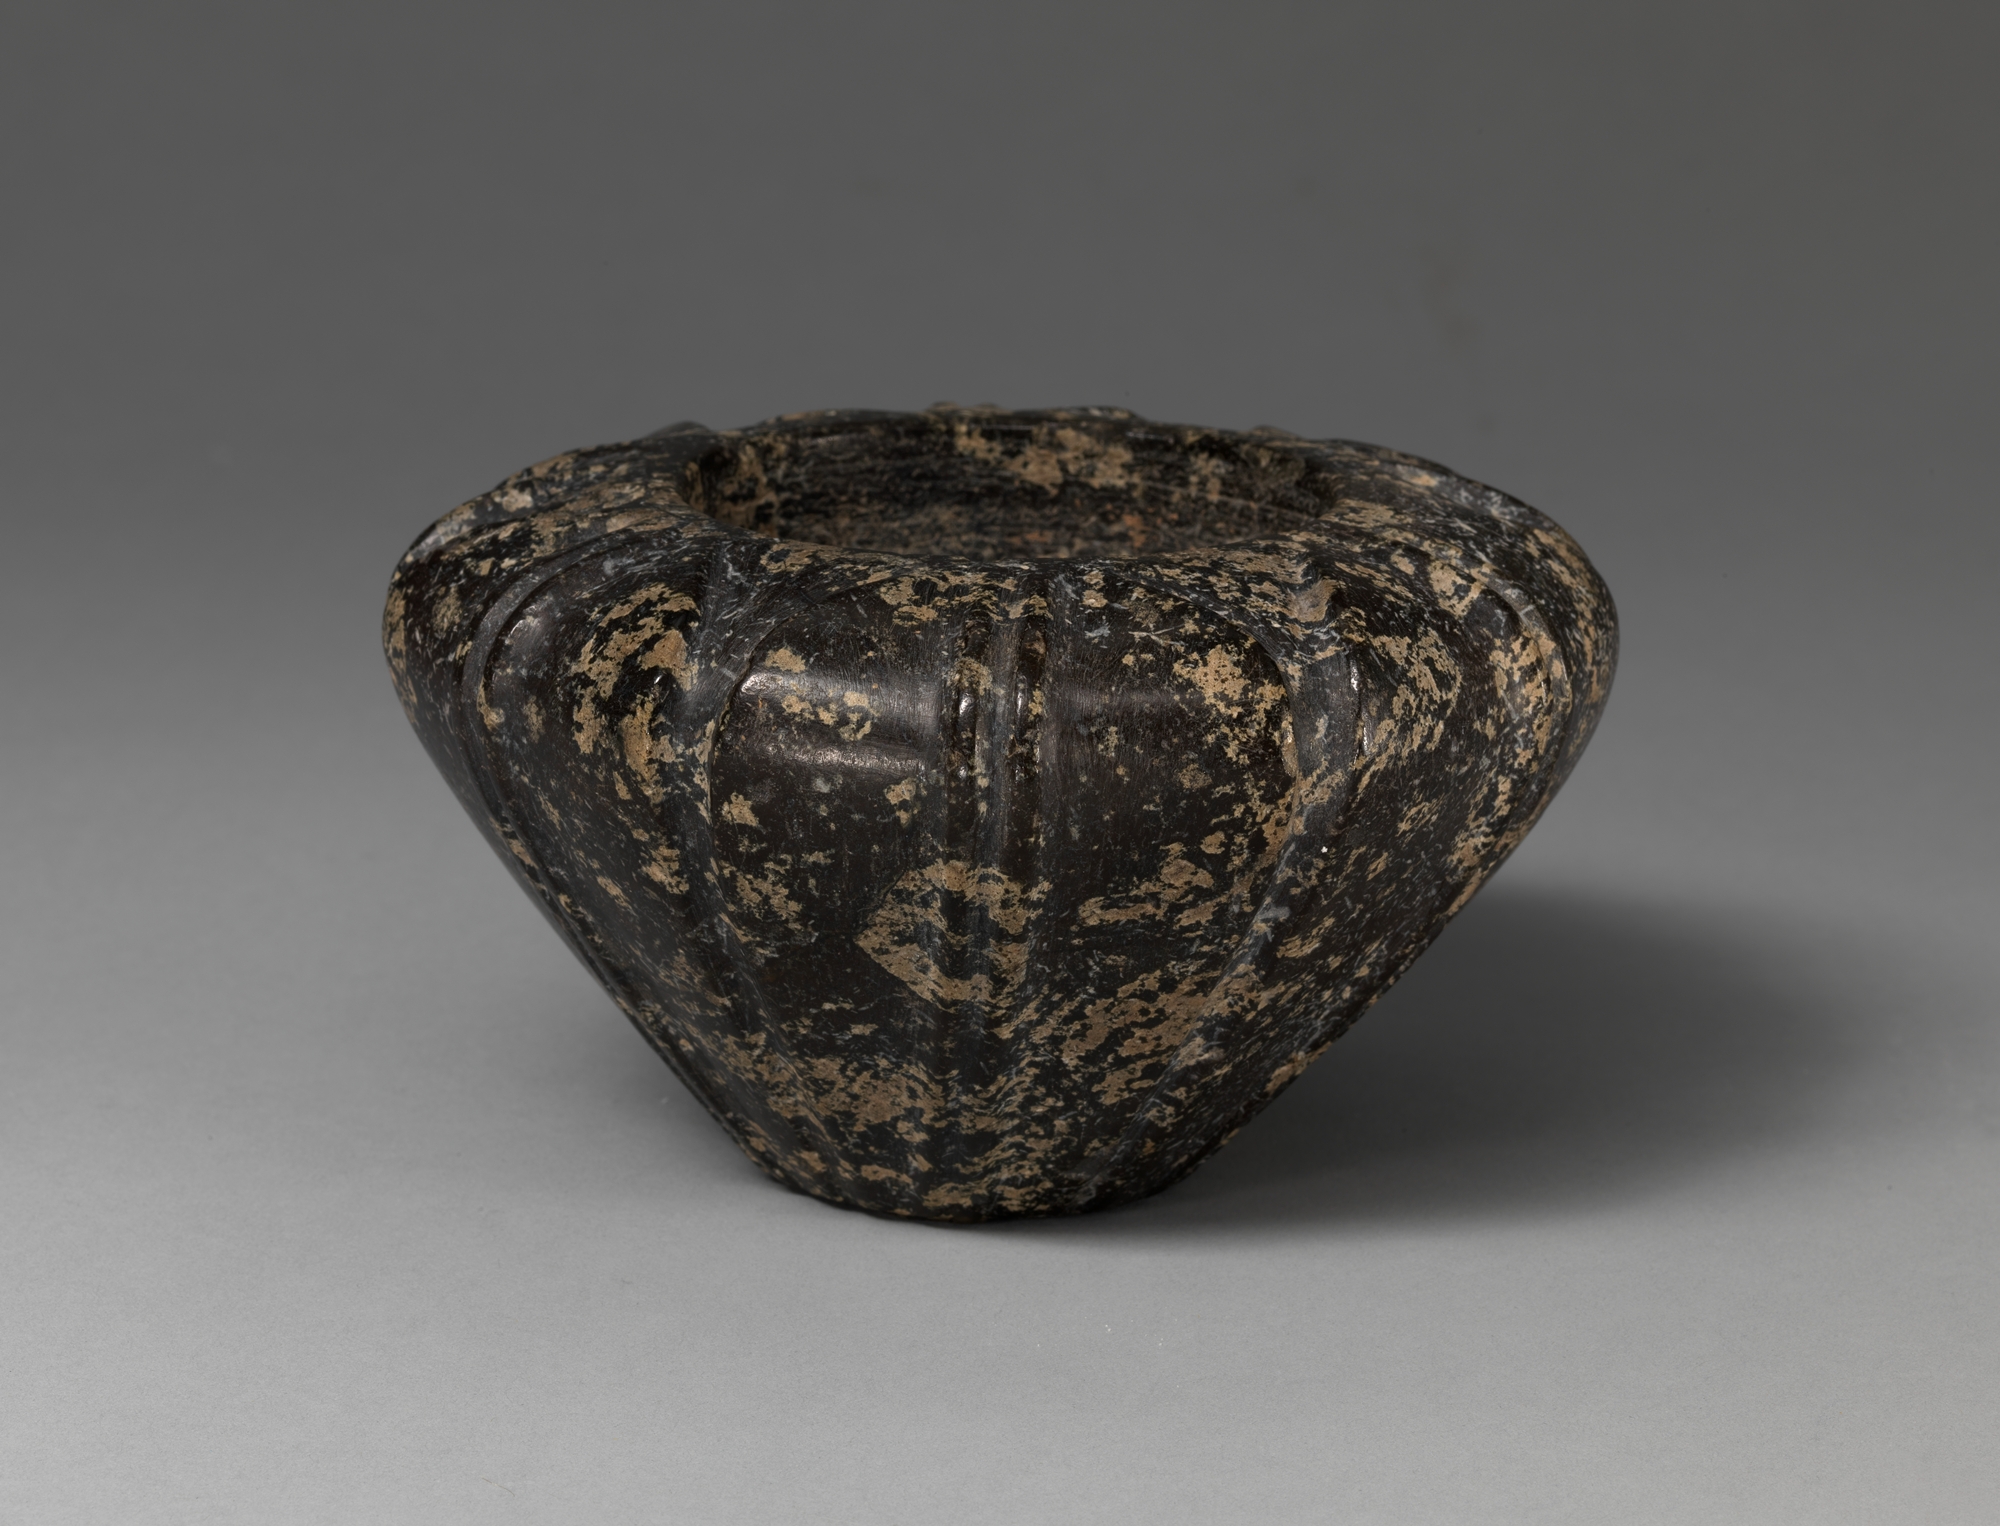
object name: blossom bowl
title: Serpentine blossom bowl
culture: minoan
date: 1600-1450 BCE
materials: stone